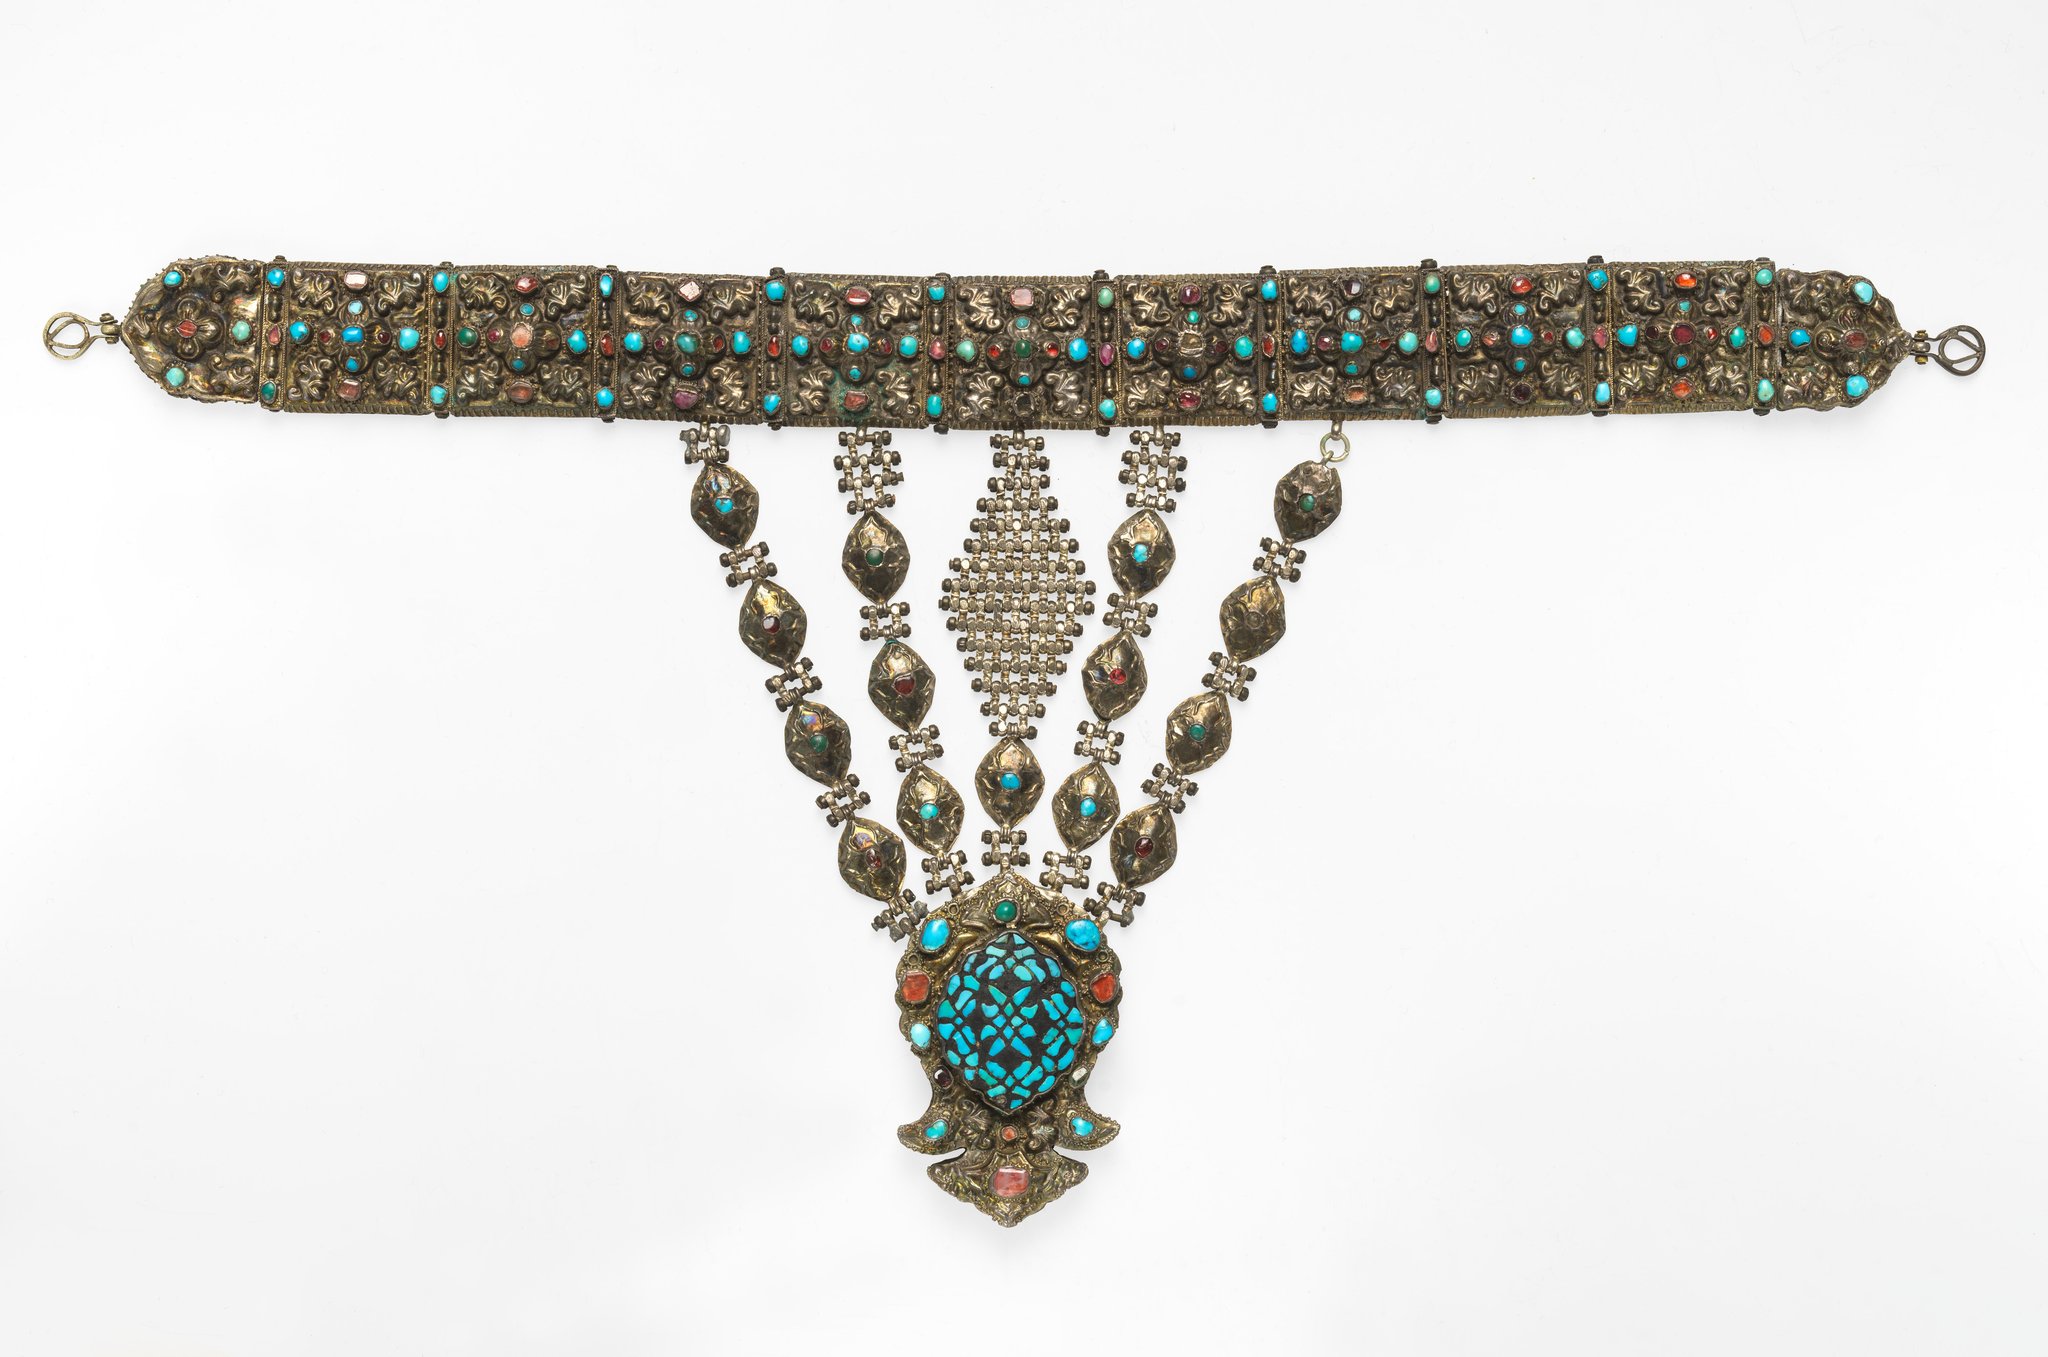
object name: necklace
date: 1801-1900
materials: silver gilt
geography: india